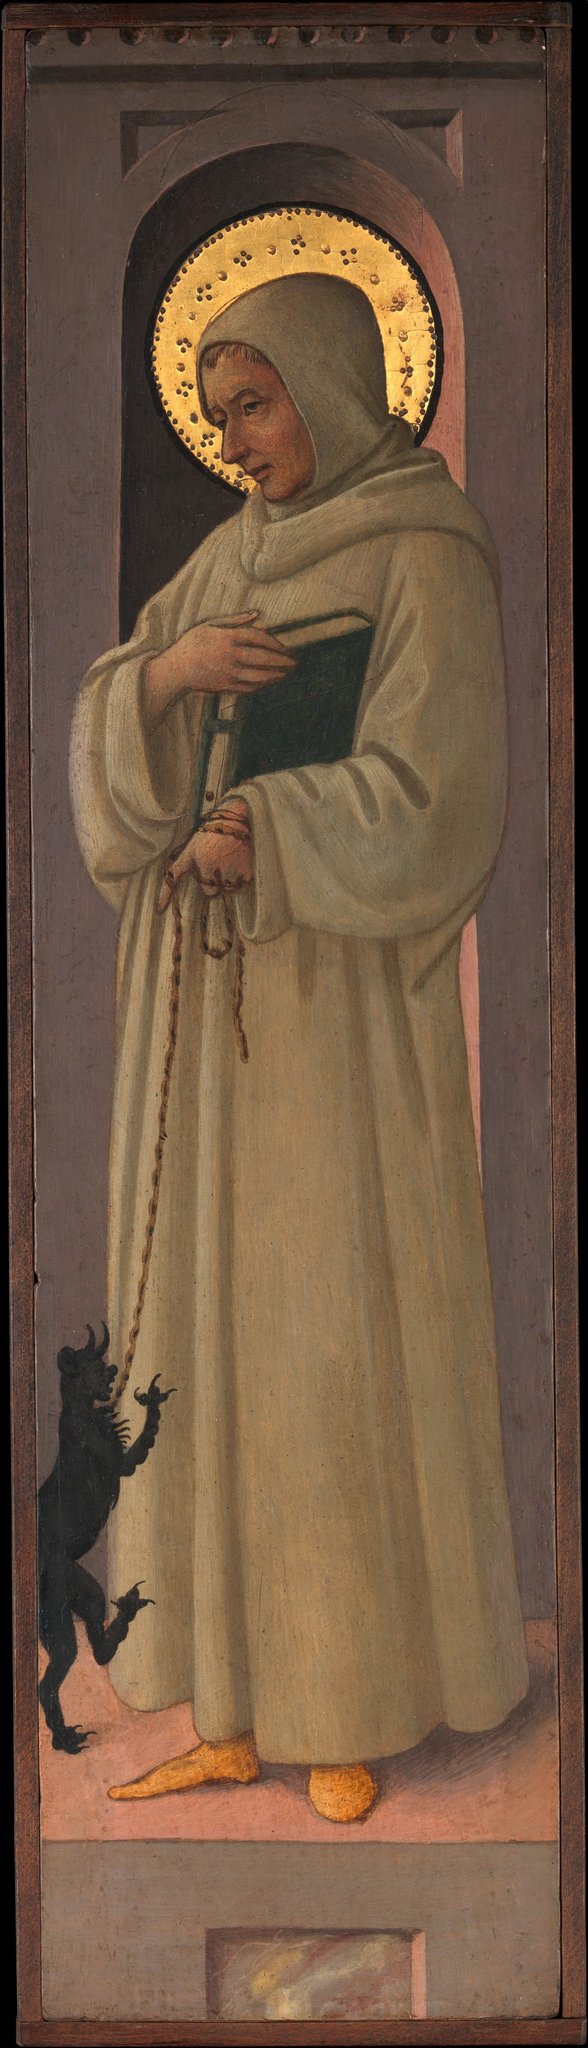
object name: painting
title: Saint Bernard of Clairvaux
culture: italian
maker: workshop of fra filippo lippi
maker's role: artist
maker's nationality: italian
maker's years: 1406-1469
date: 1447-1469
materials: gold, paint, wood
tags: men,devil,saints